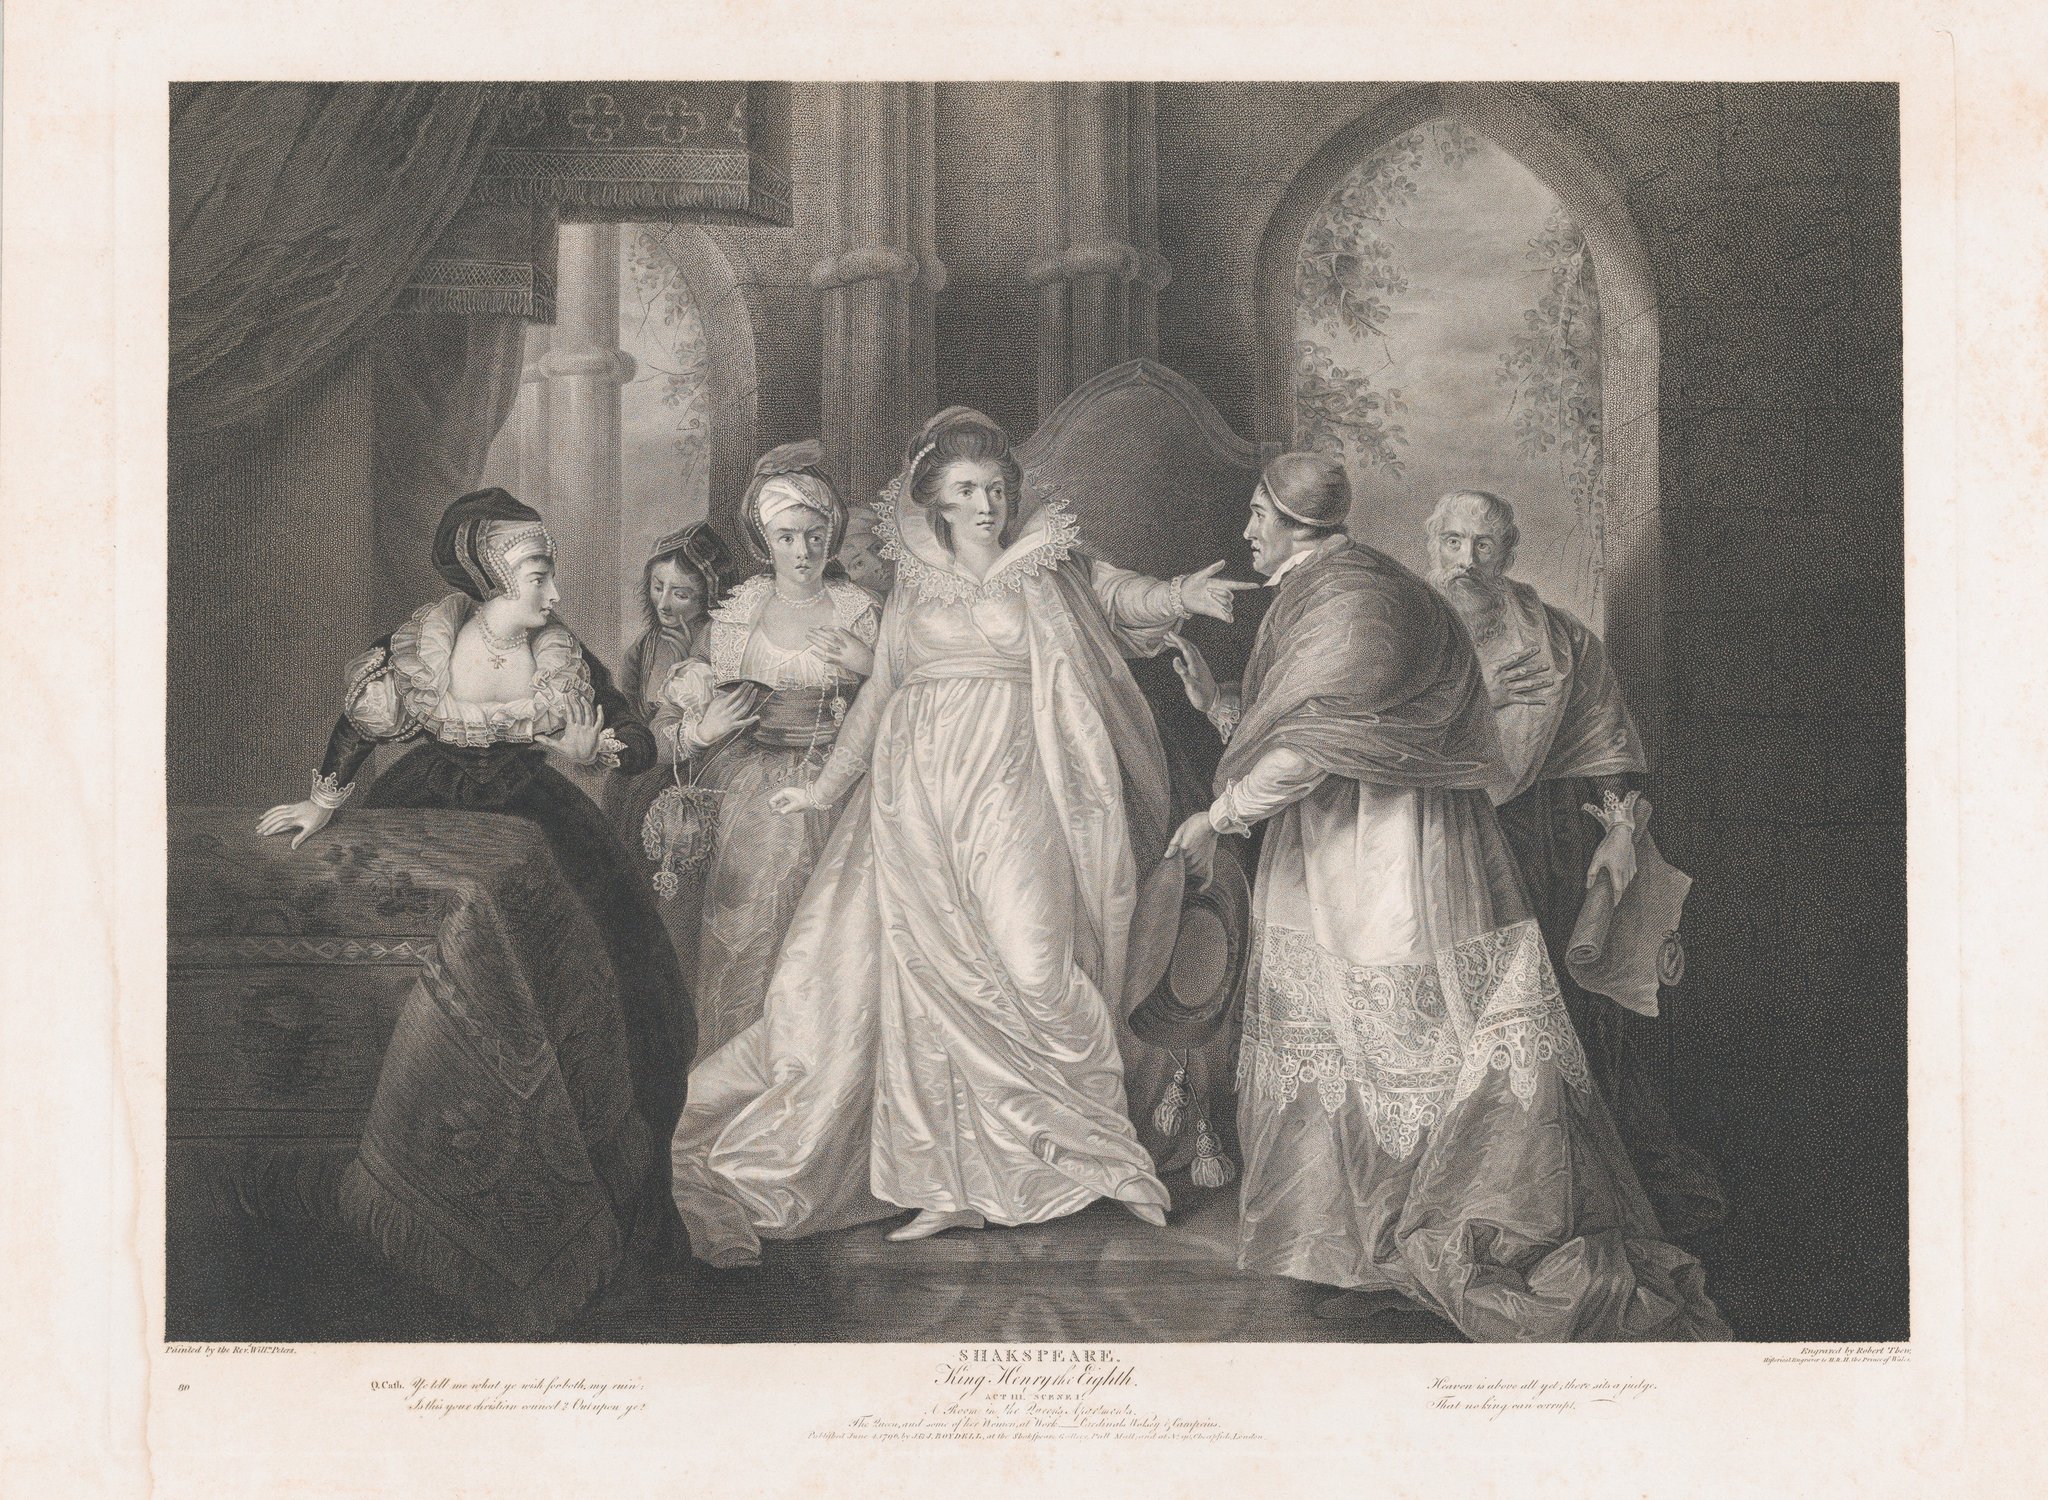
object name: print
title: Queen Catherine, Cardinal Wolsey and Cardinal Campeius (Shakespeare, King Henry VIII, Act 3, Scene 1)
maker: robert thew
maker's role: engraver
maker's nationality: british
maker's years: 1758-1802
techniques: engraving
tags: queens,shakespeare,men,women